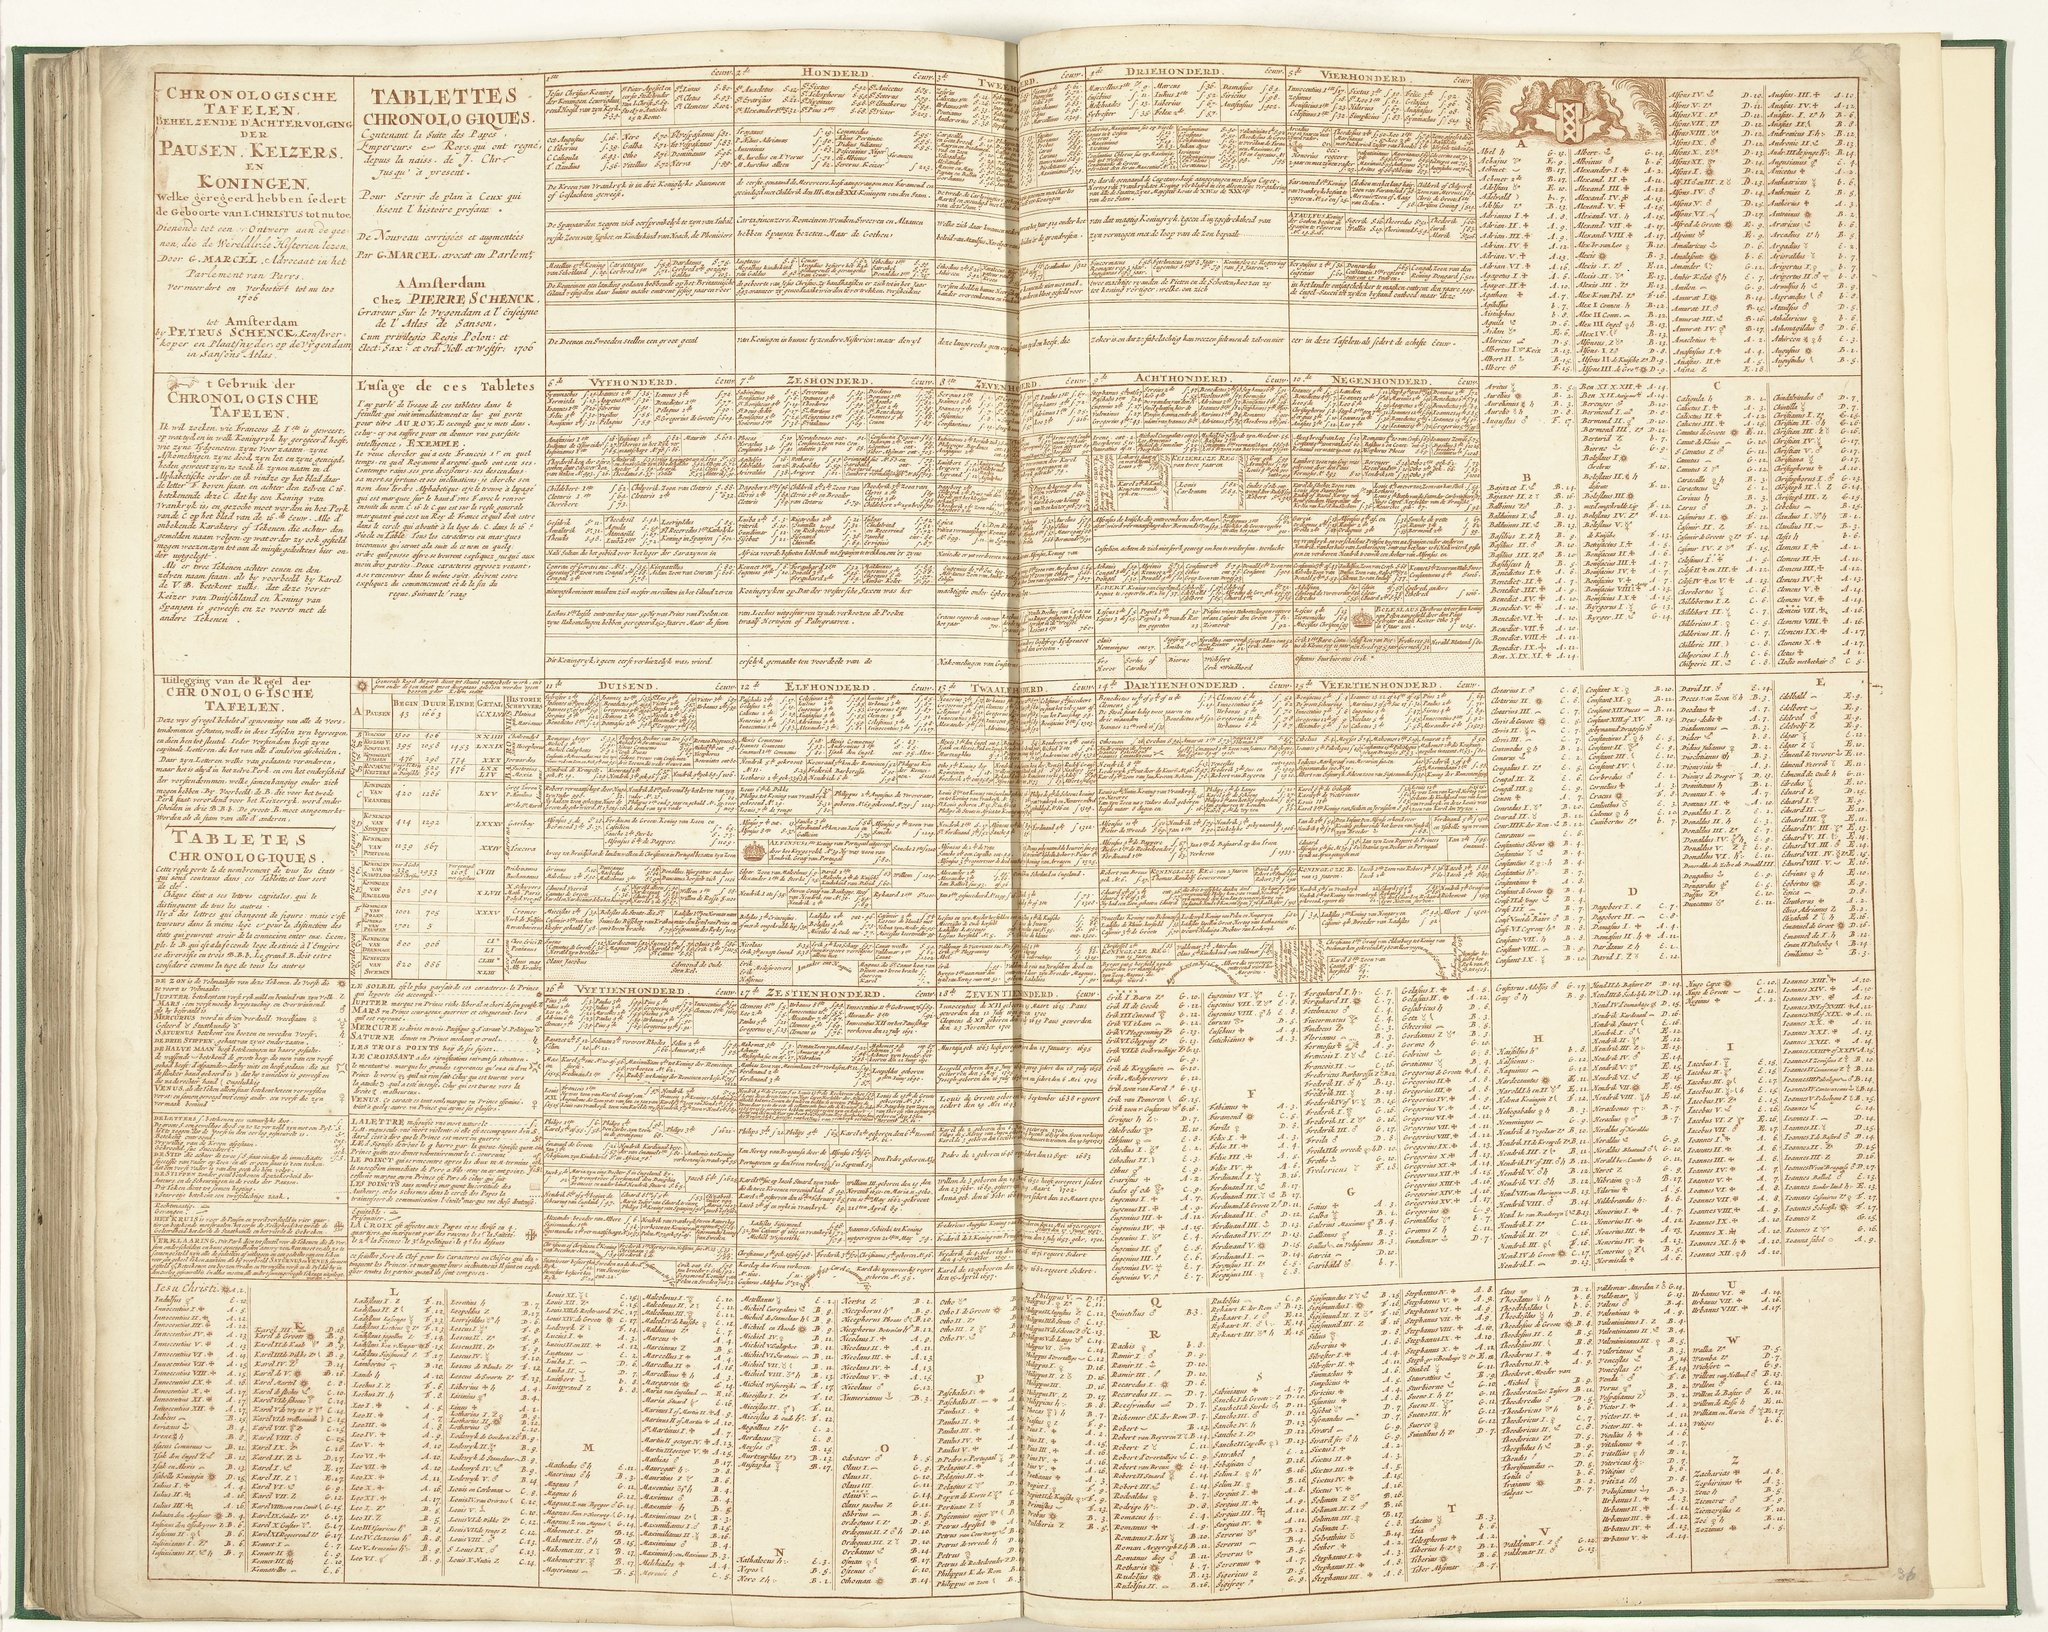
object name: print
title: Schouwburg van den oorlog (blad XXXVI), 1706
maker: pieter schenk (i)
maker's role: print maker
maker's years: 1660-1711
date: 1706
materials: paper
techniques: etching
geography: amsterdam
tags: spaanse successieoorlog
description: Blad met chronologische lijsten van de pausen en wereldlijke vorsten vanaf het jaar nul tot 1706. Het blad bevat alleen tekst, geen voorstelling, alle opschriften in het Nederlands. Blad XXXVI in: Schouwburg van den oorlog (editie van 1720), het prentwerk met de gebundelde reeks van 31 platen over de Spaanse Successieoorlog.